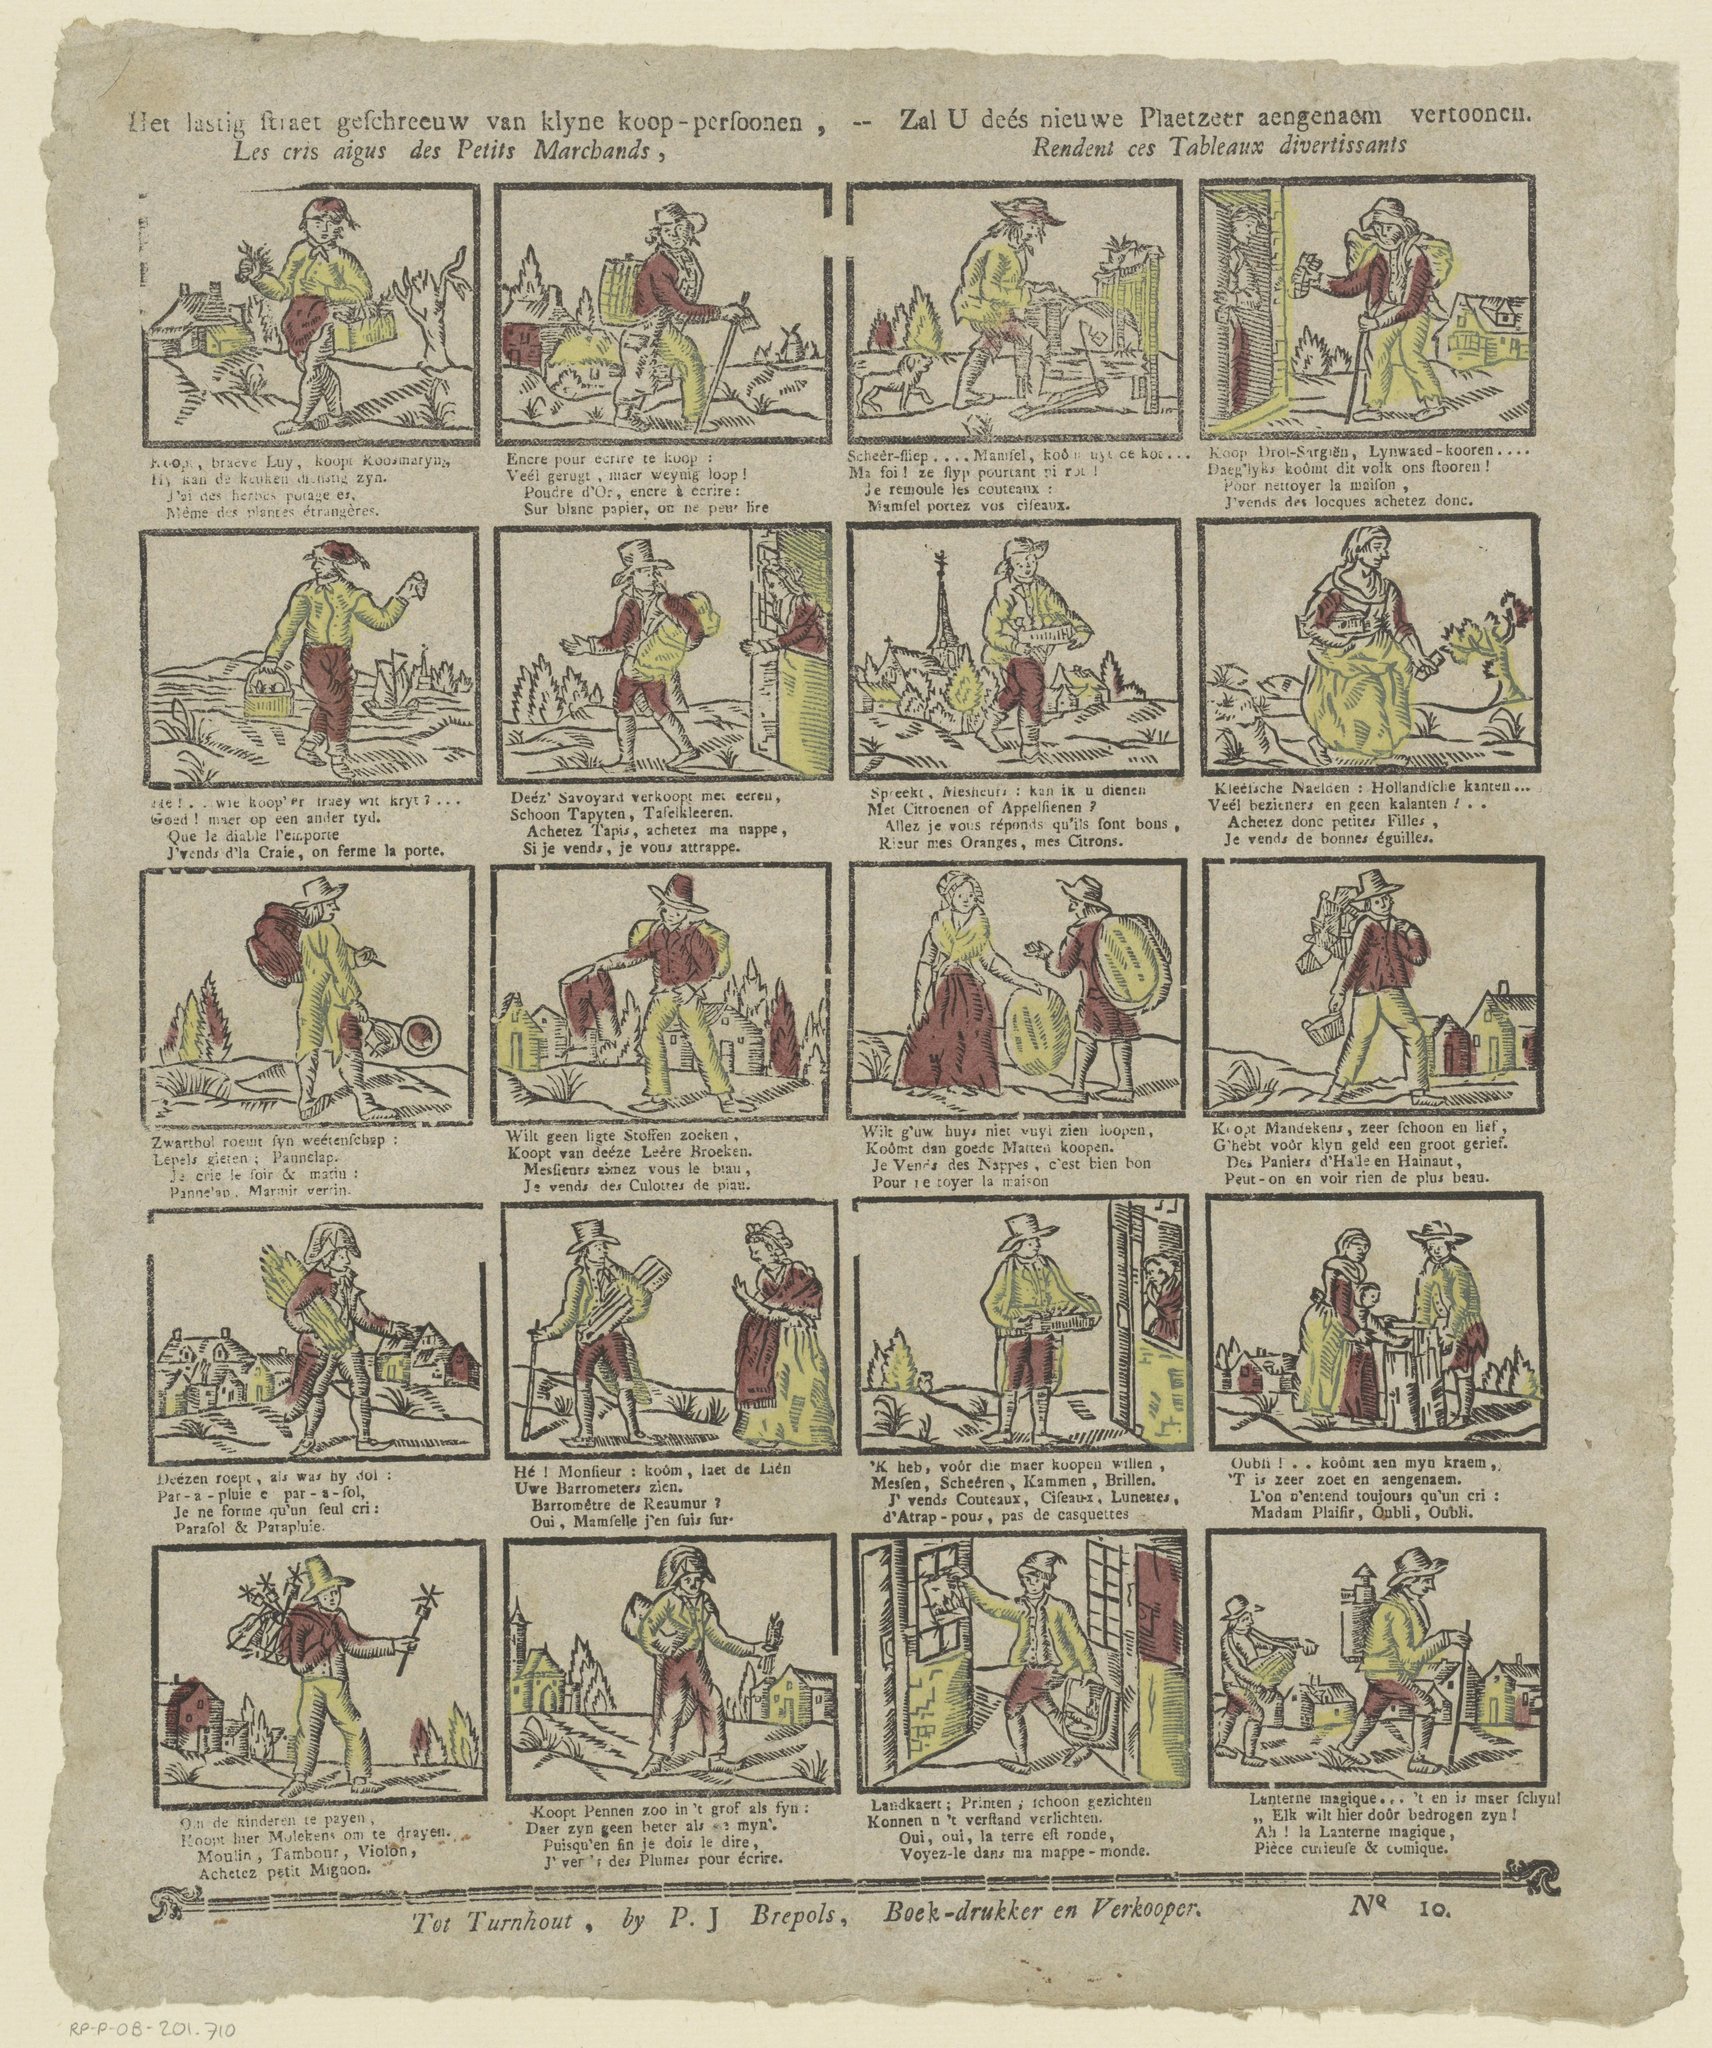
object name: popular print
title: Het lastig straet geschreeuw van klyne koop-persoonen, / Zal u deés nieuwe plaet zeer aengenaem vertoonen / Les cris aigus des petits marchands, / Rendent ce tableau divertissants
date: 1800-1833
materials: paper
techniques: colour, letterpress printing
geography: turnhout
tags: street-trader, merchant, salesman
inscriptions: collector's mark: Lugt 2760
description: Blad met 20 voorstellingen van straatverkopers, zoals een krijtverkoper, een mattenverkoper en een prentenverkoper. Onder elke afbeelding een tweeregelig vers in het Nederlands en in het Frans. Genummerd rechtsonder: No 10.